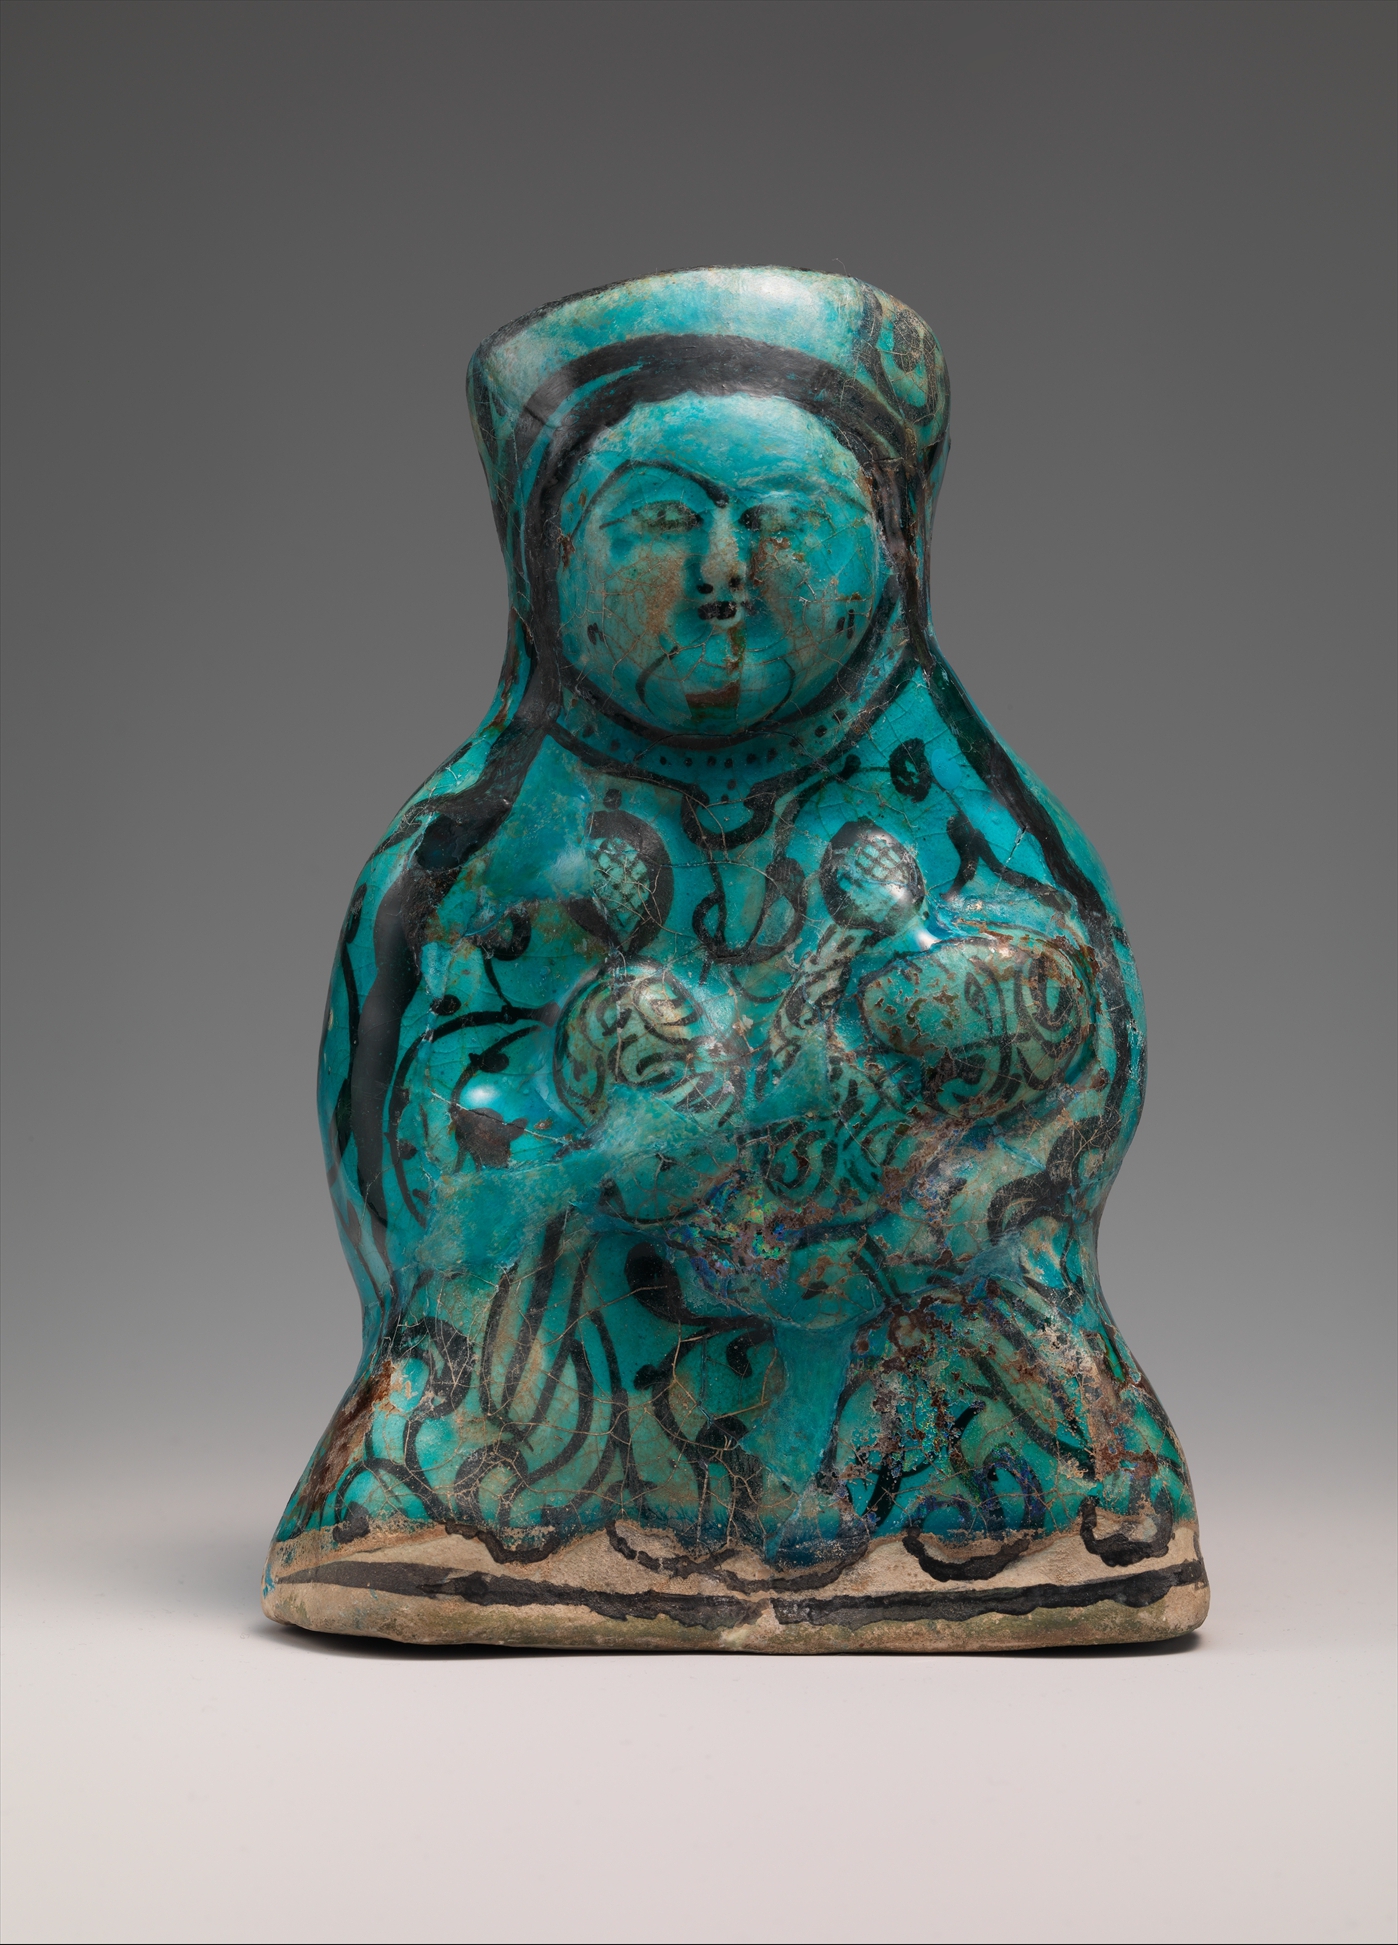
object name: figural vessel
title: Molded Vessel in the Form of a Mother and Child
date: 1101-1300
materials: glaze, stonepaste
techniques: molding, painting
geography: iran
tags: infants,mothers,women